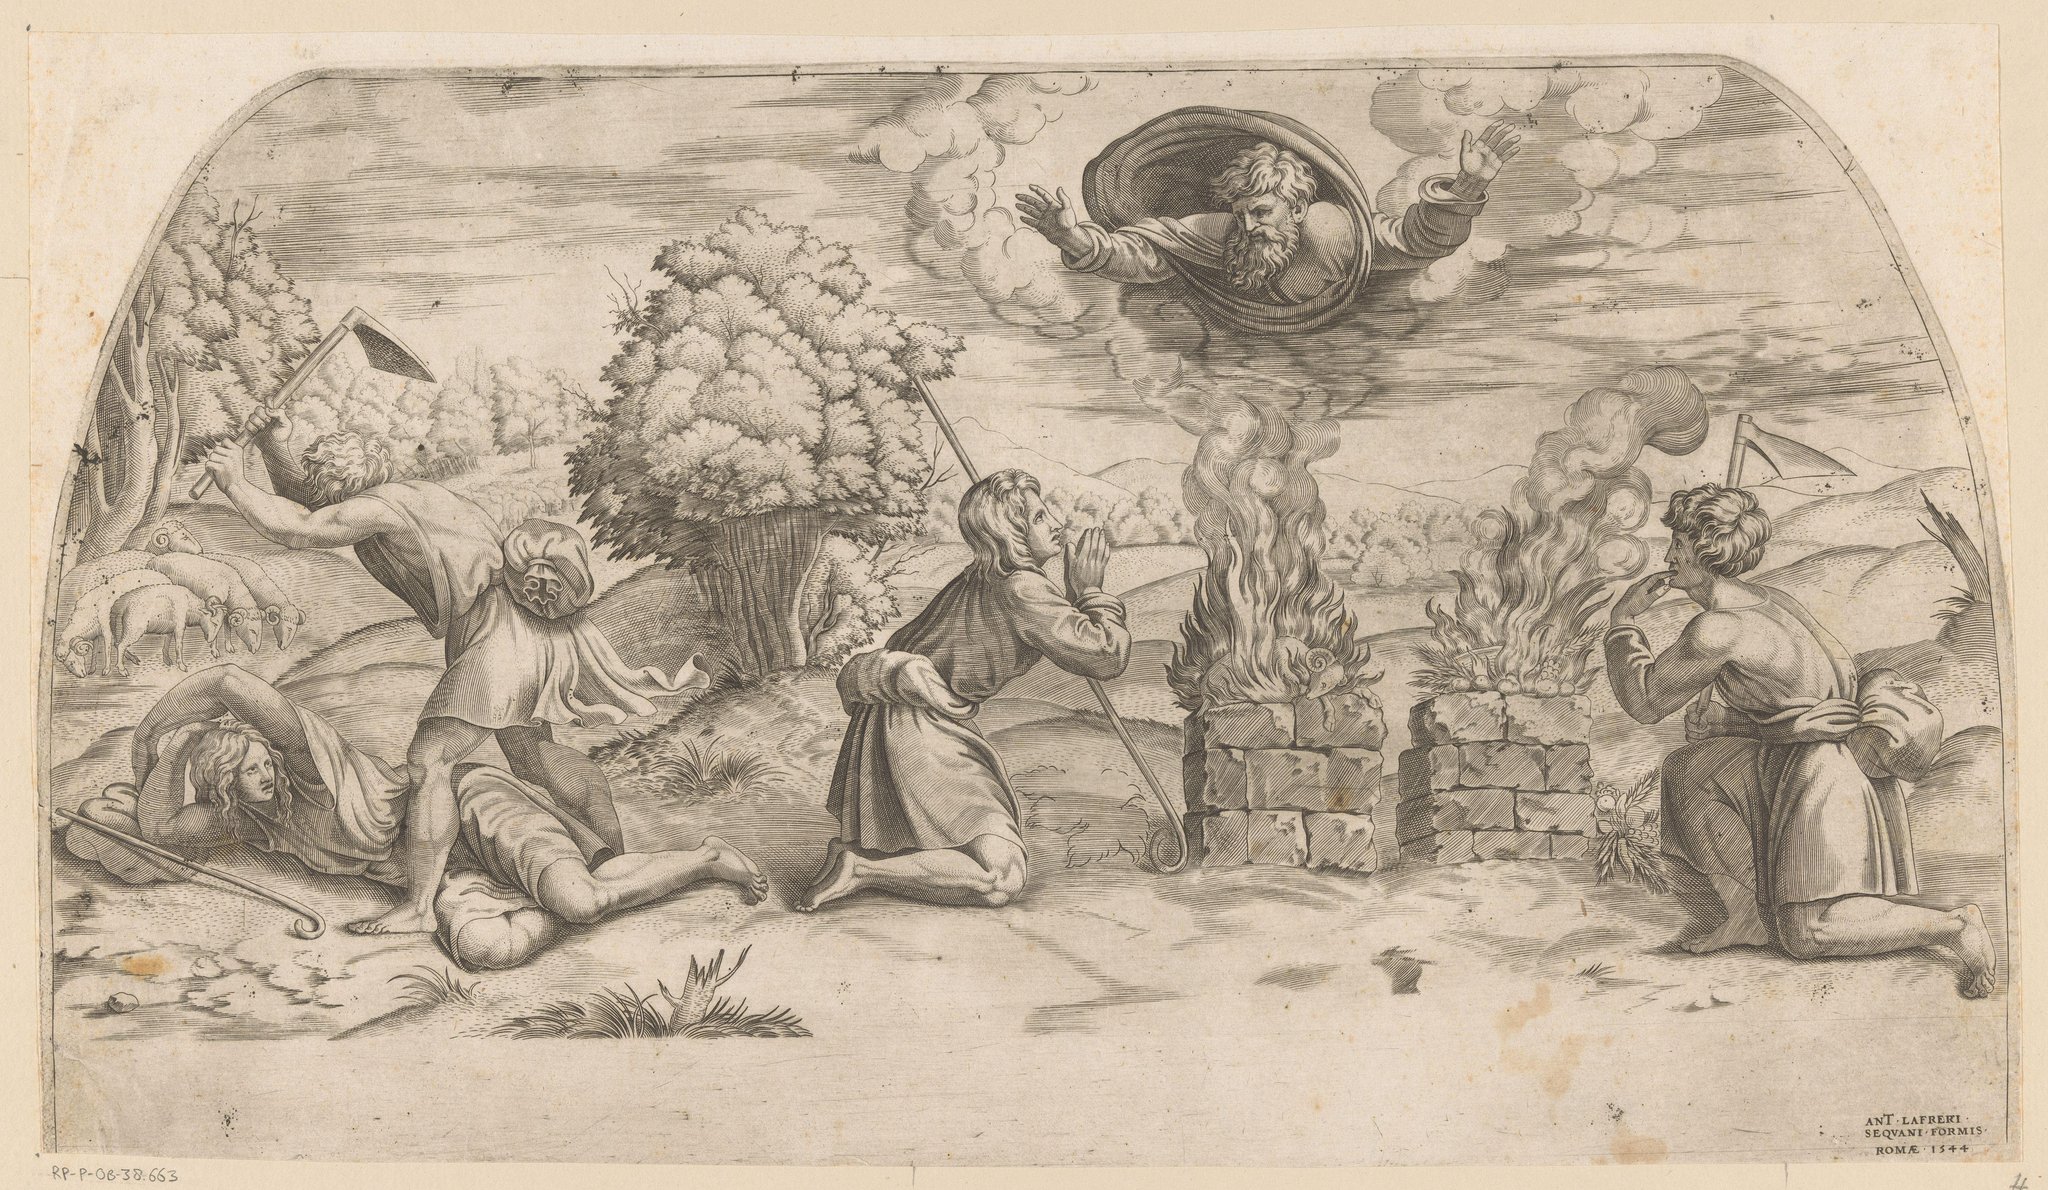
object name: print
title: Kaïn en Abel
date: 1544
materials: paper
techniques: engraving, intaglio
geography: rome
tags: the killing of abel: cain slays him with a stone, a club or a jaw-bone, alternatively with a spade or another tool as weapon, the sacrifice of cain and abel: abel offers a lamb, cain usually a sheaf of corn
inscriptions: collector's mark: Lugt 240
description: Rechts de offers van Kaïn en Abel. Kaïn brengt een offer van zijn oogst en Abel offert een lam. Links Abel die door Kaïn wordt gedood.